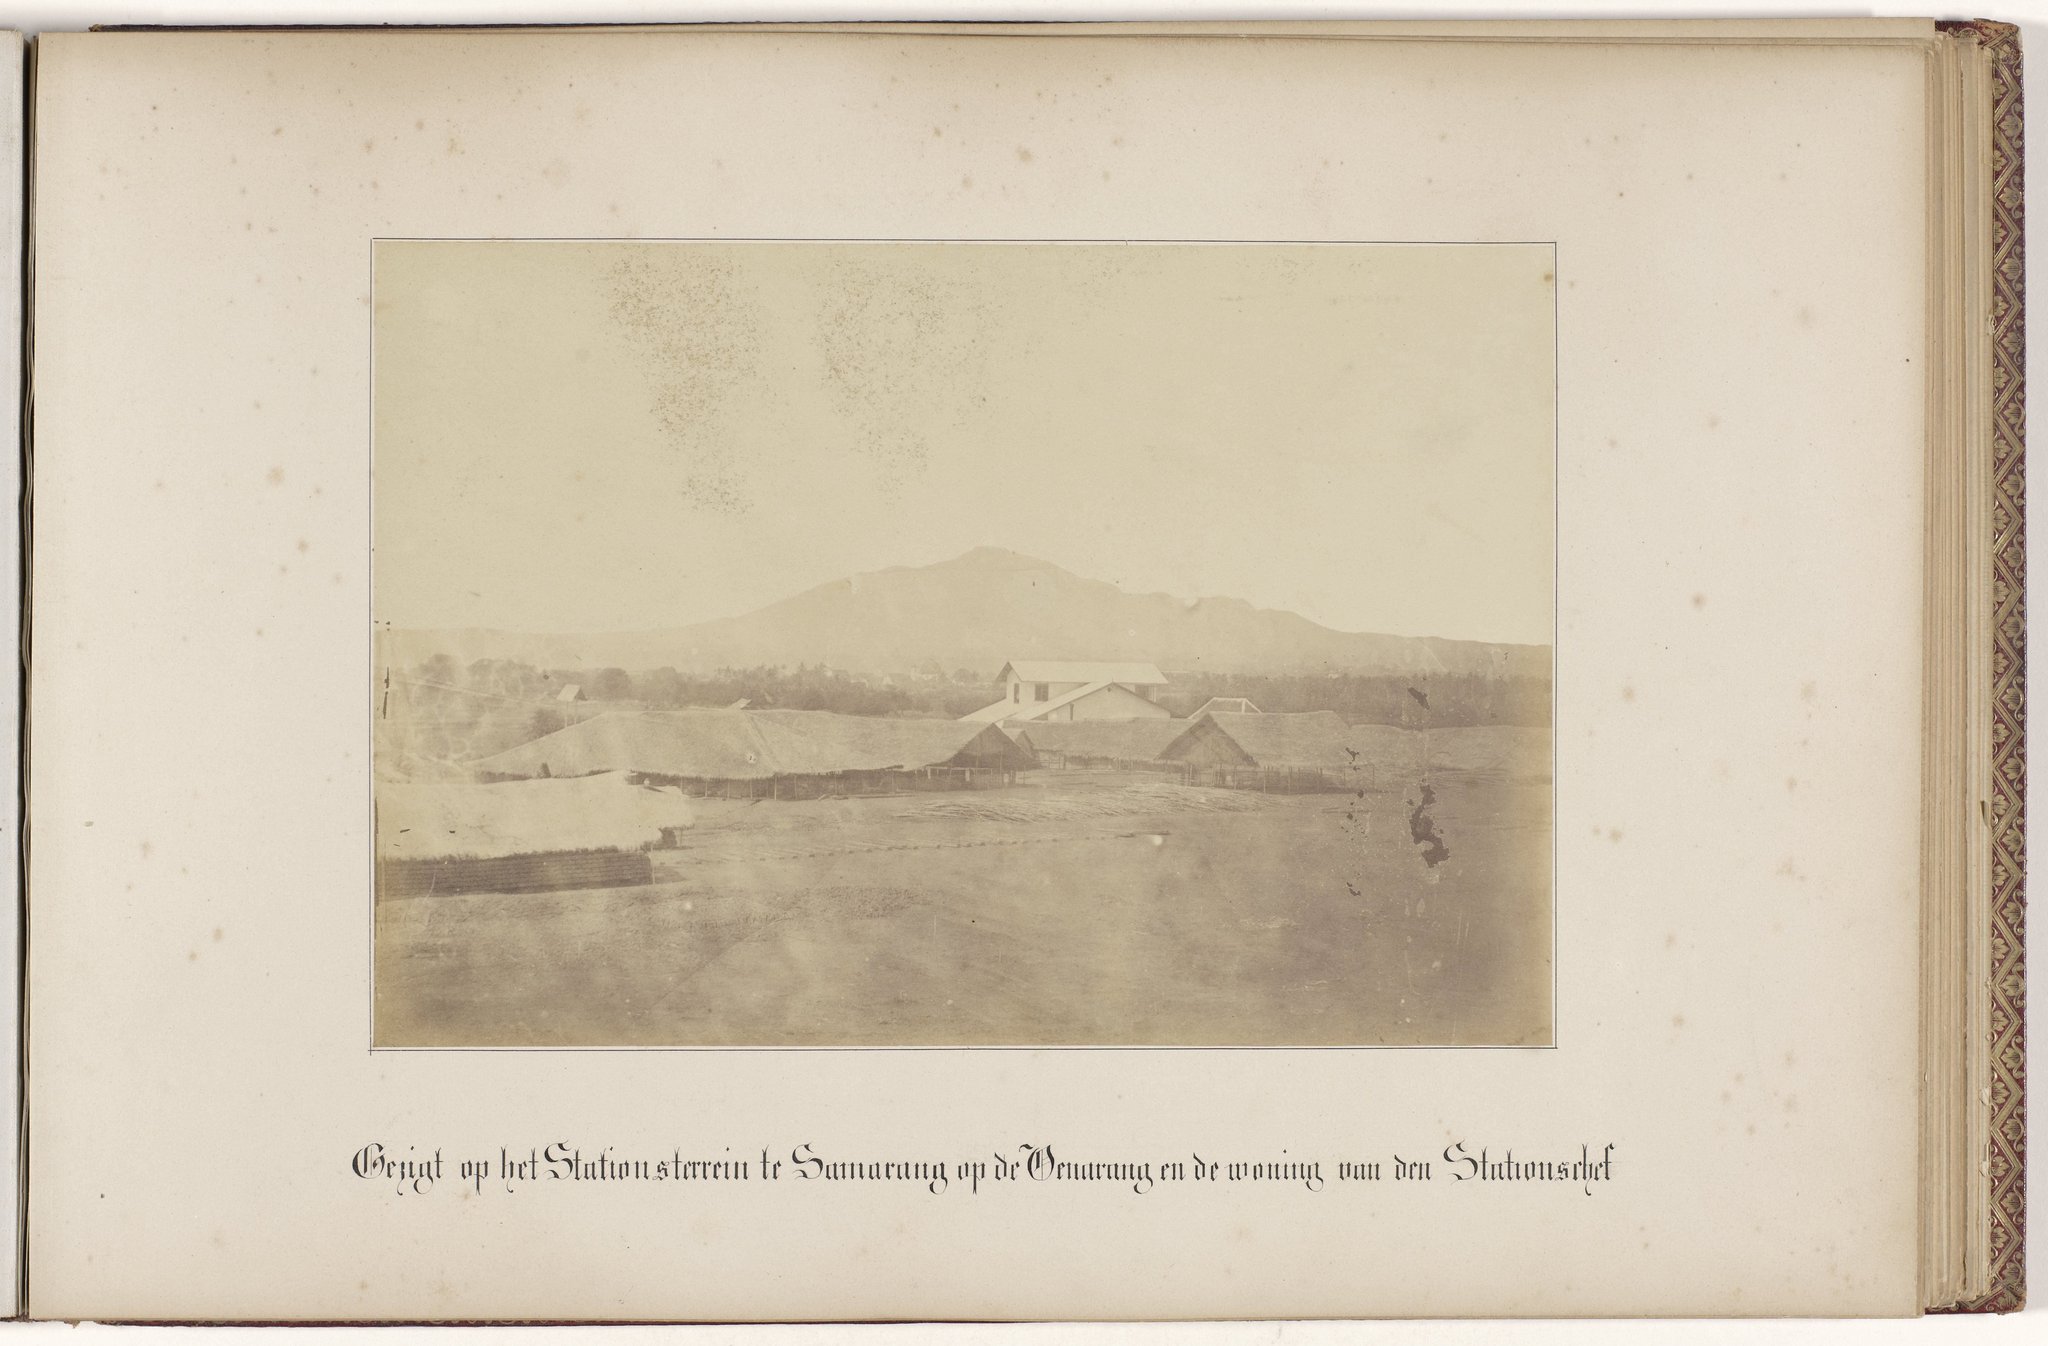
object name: photograph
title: Gezigt op het Stationsterrein te Samarang op de Venarang en de woning van den Stationschef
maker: carl emanuel friedrich lang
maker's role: draughtsman, print maker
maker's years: -1906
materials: cardboard, photographic support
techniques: albumen print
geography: java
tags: colonial system, railway-traffic, station; shelter (railway, tramway), building-site, java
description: Gezicht op het stationsterrein te Semarang, met enkele open gebouwen bedekt met atap en de woning van de stationschef. Albumblad met opgeplakte foto, onderdeel van het fotoalbum over de aanleg van de spoorlijn Semarang - Kedoeng Djattie (Kedungjati) op Java in 1865.